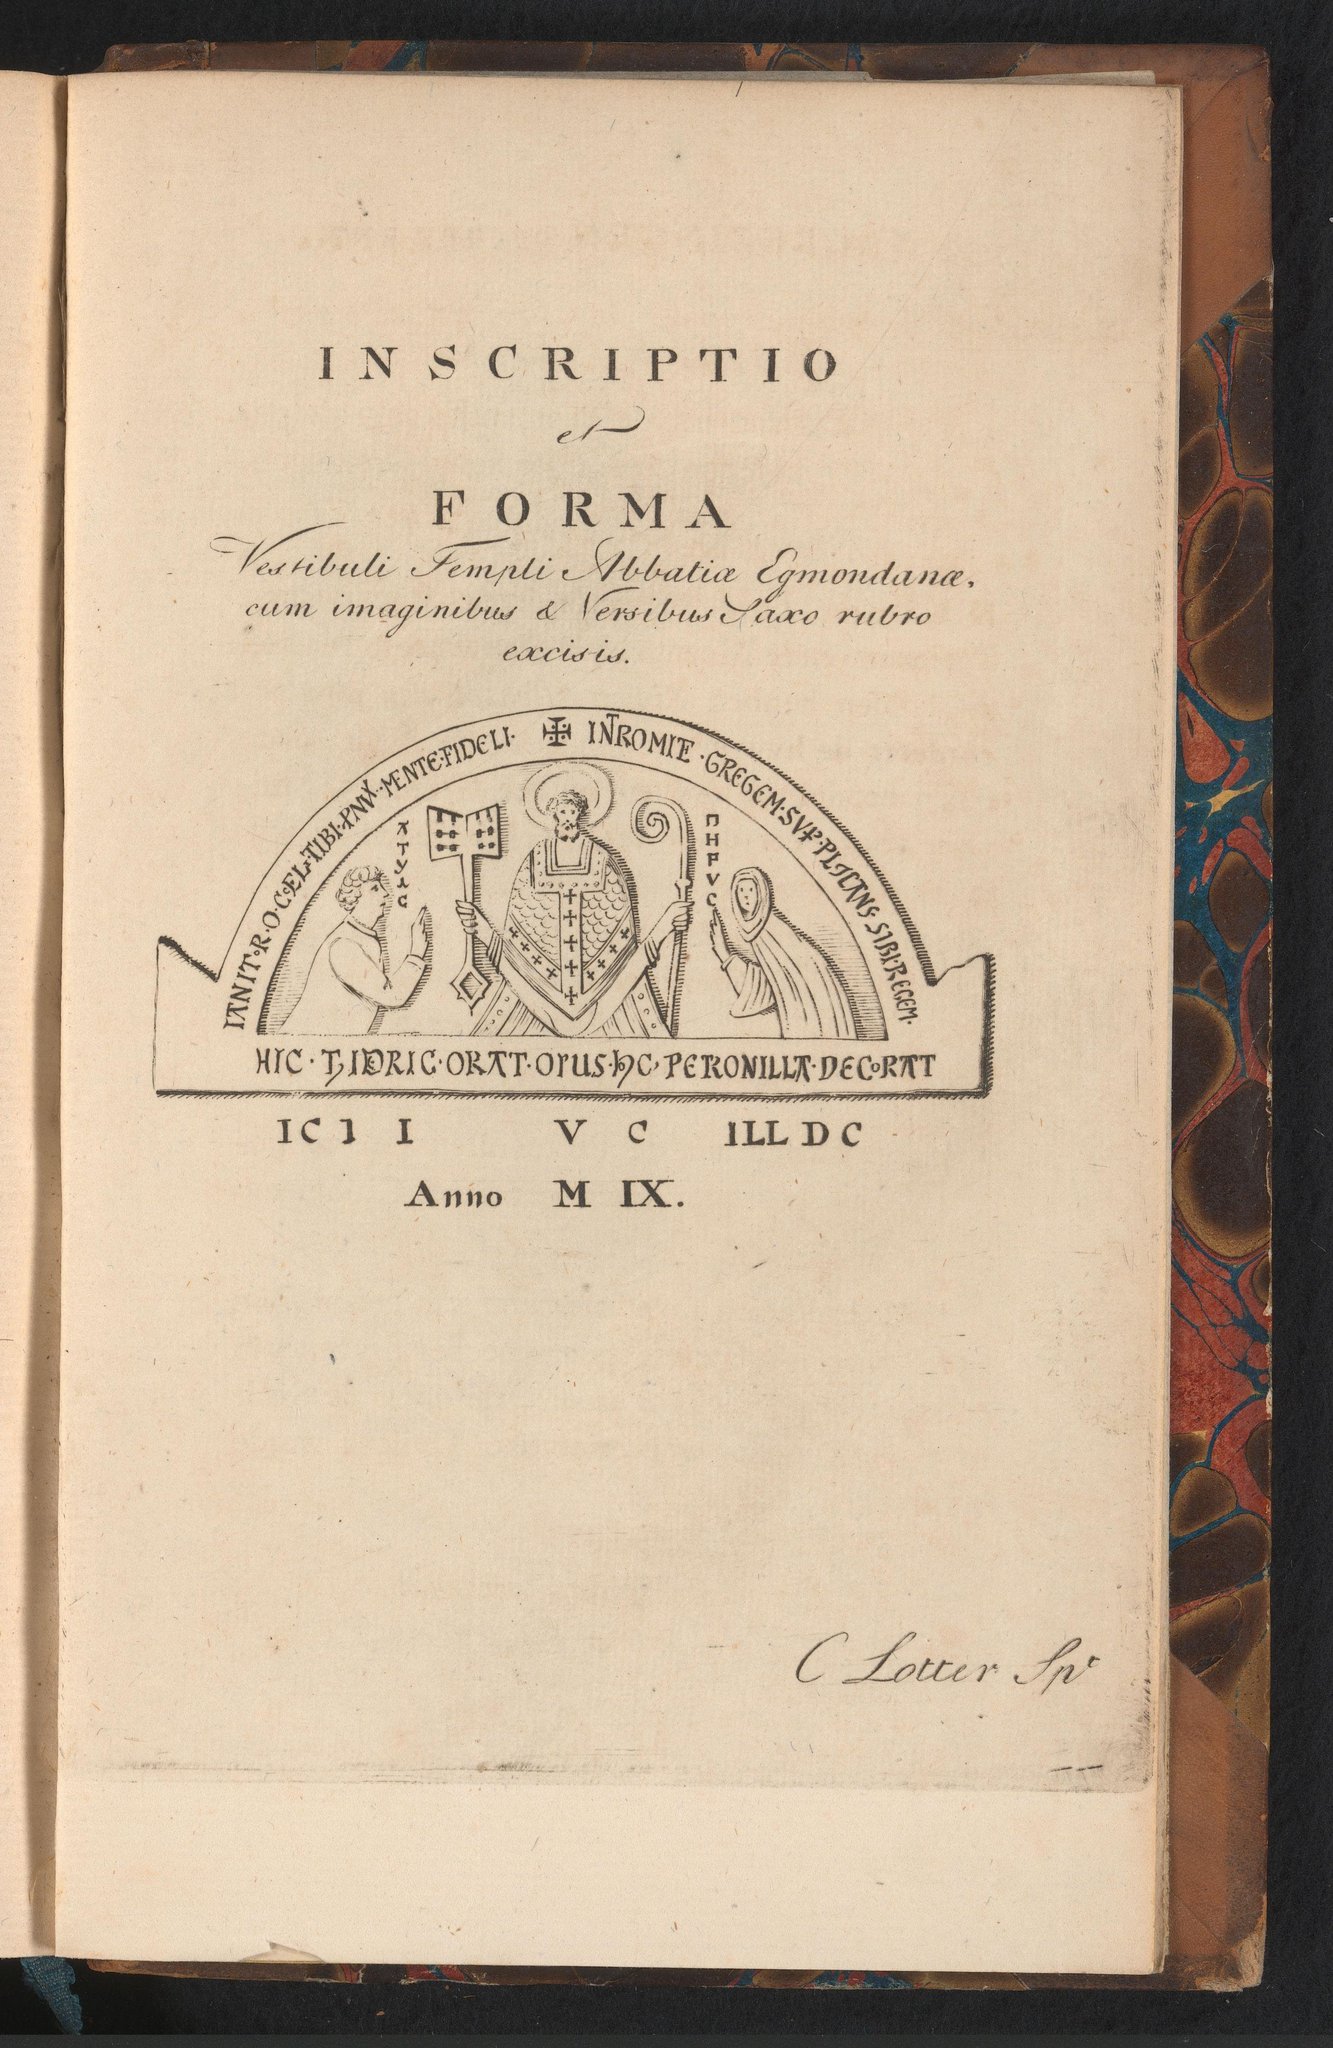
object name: historical object representation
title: Inscriptio & Forma Vestibuli Templi Abbatiae Egmondane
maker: christian anthony lotter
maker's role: print maker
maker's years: 1787-1838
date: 1800-1805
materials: paper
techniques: etching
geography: netherlands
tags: piece of sculpture, reproduction of a piece of sculpture, art (+ relief ~ sculpture)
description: Timpaan van Egmond: boogtrommel met Petrus, graaf Dirk VI van Holland en zijn moeder gravin Petronella. Het geheel omringd met Latijnse inscripties. De steen is afkomstig uit de voormalige Benedictijner Abdij van St. Petrus en St. Adelbert te Egmond-Binnen. Onder de steen de datering 1009, in werkelijkheid is de steen vervaardigd ca. 1120.